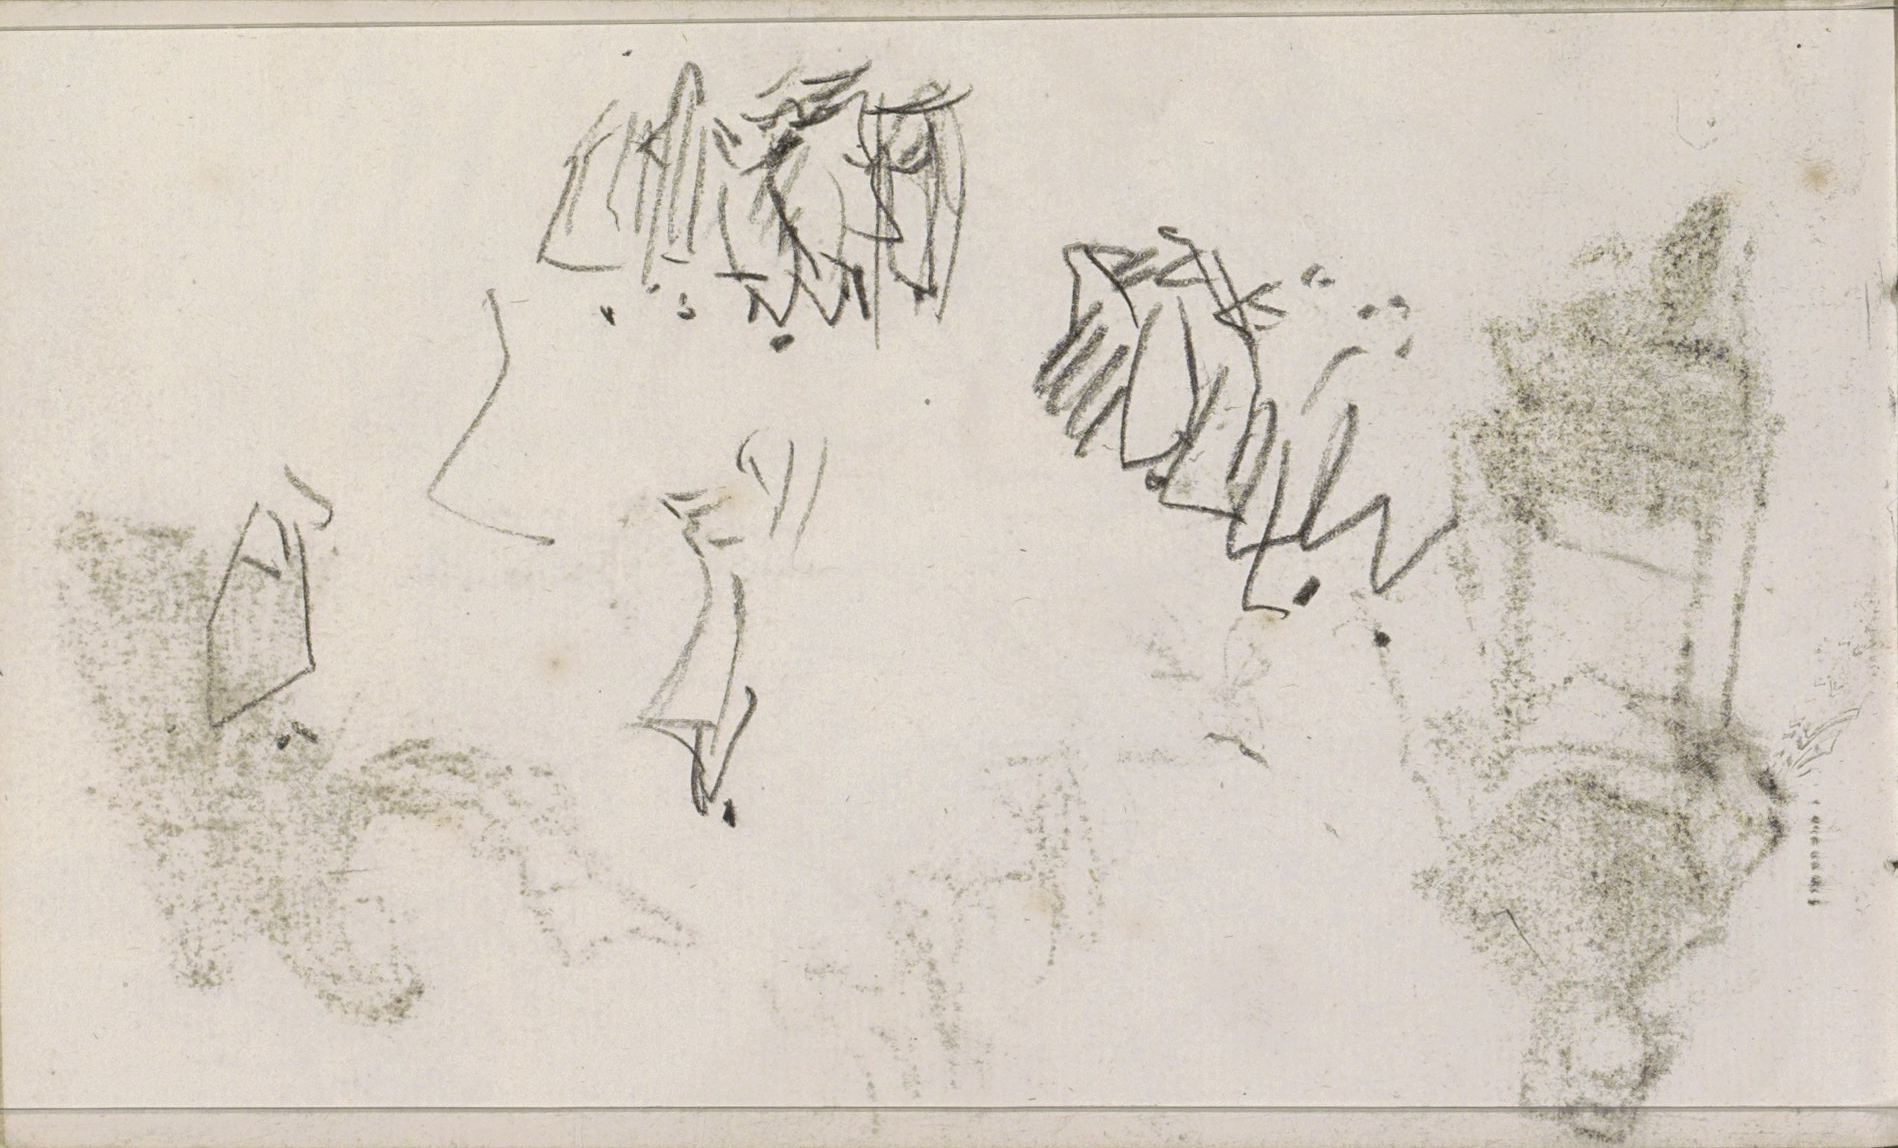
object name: sketchbook leaf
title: Figuurstudies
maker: isaac israels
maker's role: draughtsman, painter, print maker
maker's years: 1865-1934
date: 1875-1934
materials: chalk, paper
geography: the hague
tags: the (nude) human figure; 'corpo humano' (ripa)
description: Pagina 36 uit schetsboek XLVIII met 62 pagina's.